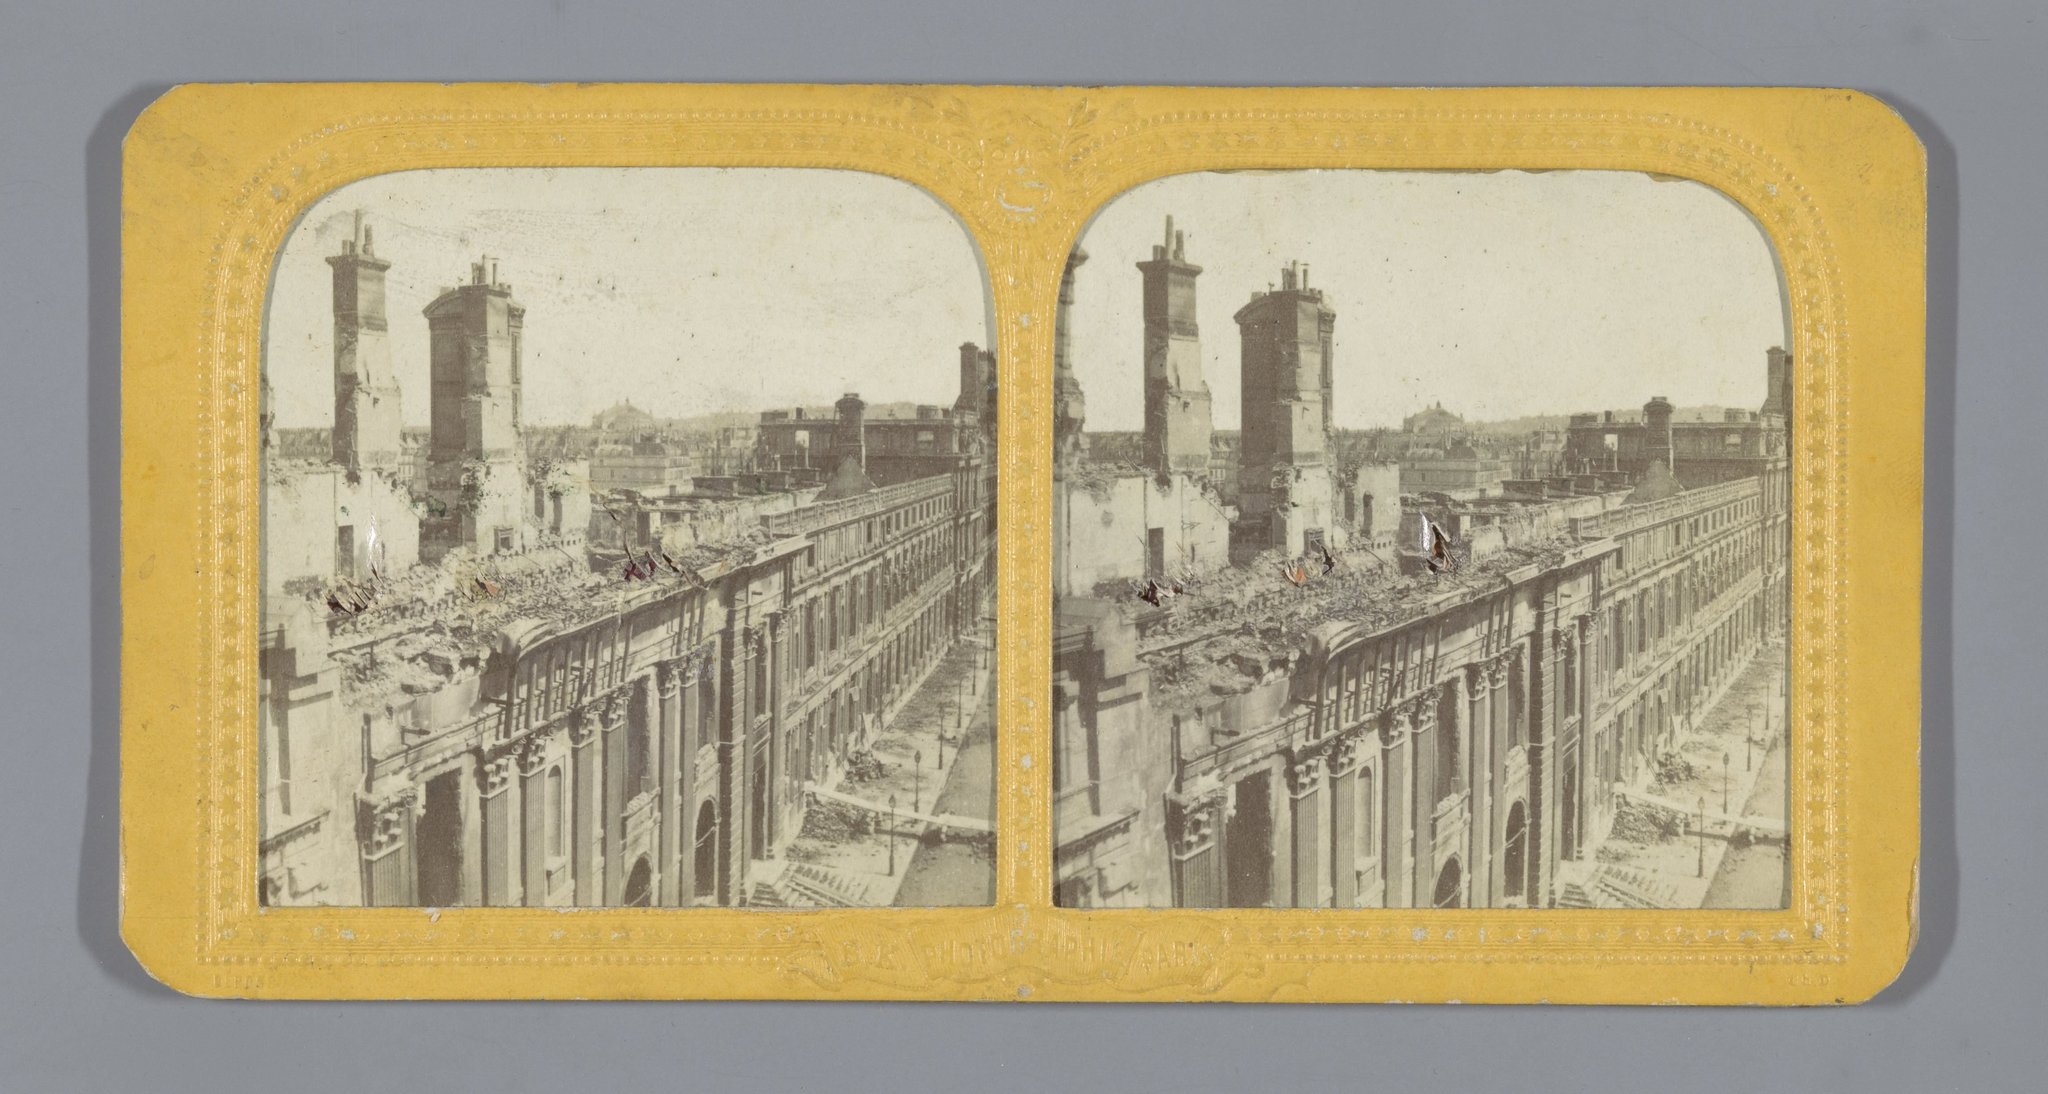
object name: tissue stereograph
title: Ruïne van het Palais des Tuileries tijdens de Commune van Parijs in 1871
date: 1871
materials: cardboard, paper, photographic support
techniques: albumen print, cutting, hand coloring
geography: paris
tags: palace, devastated, ruined place or city (~ warfare), tuileries palace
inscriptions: inscription: ‘Ch D’, inscription: ‘Déposé’, check stamp: ‘B.K. PHOTOGRAPHIE PARIS’